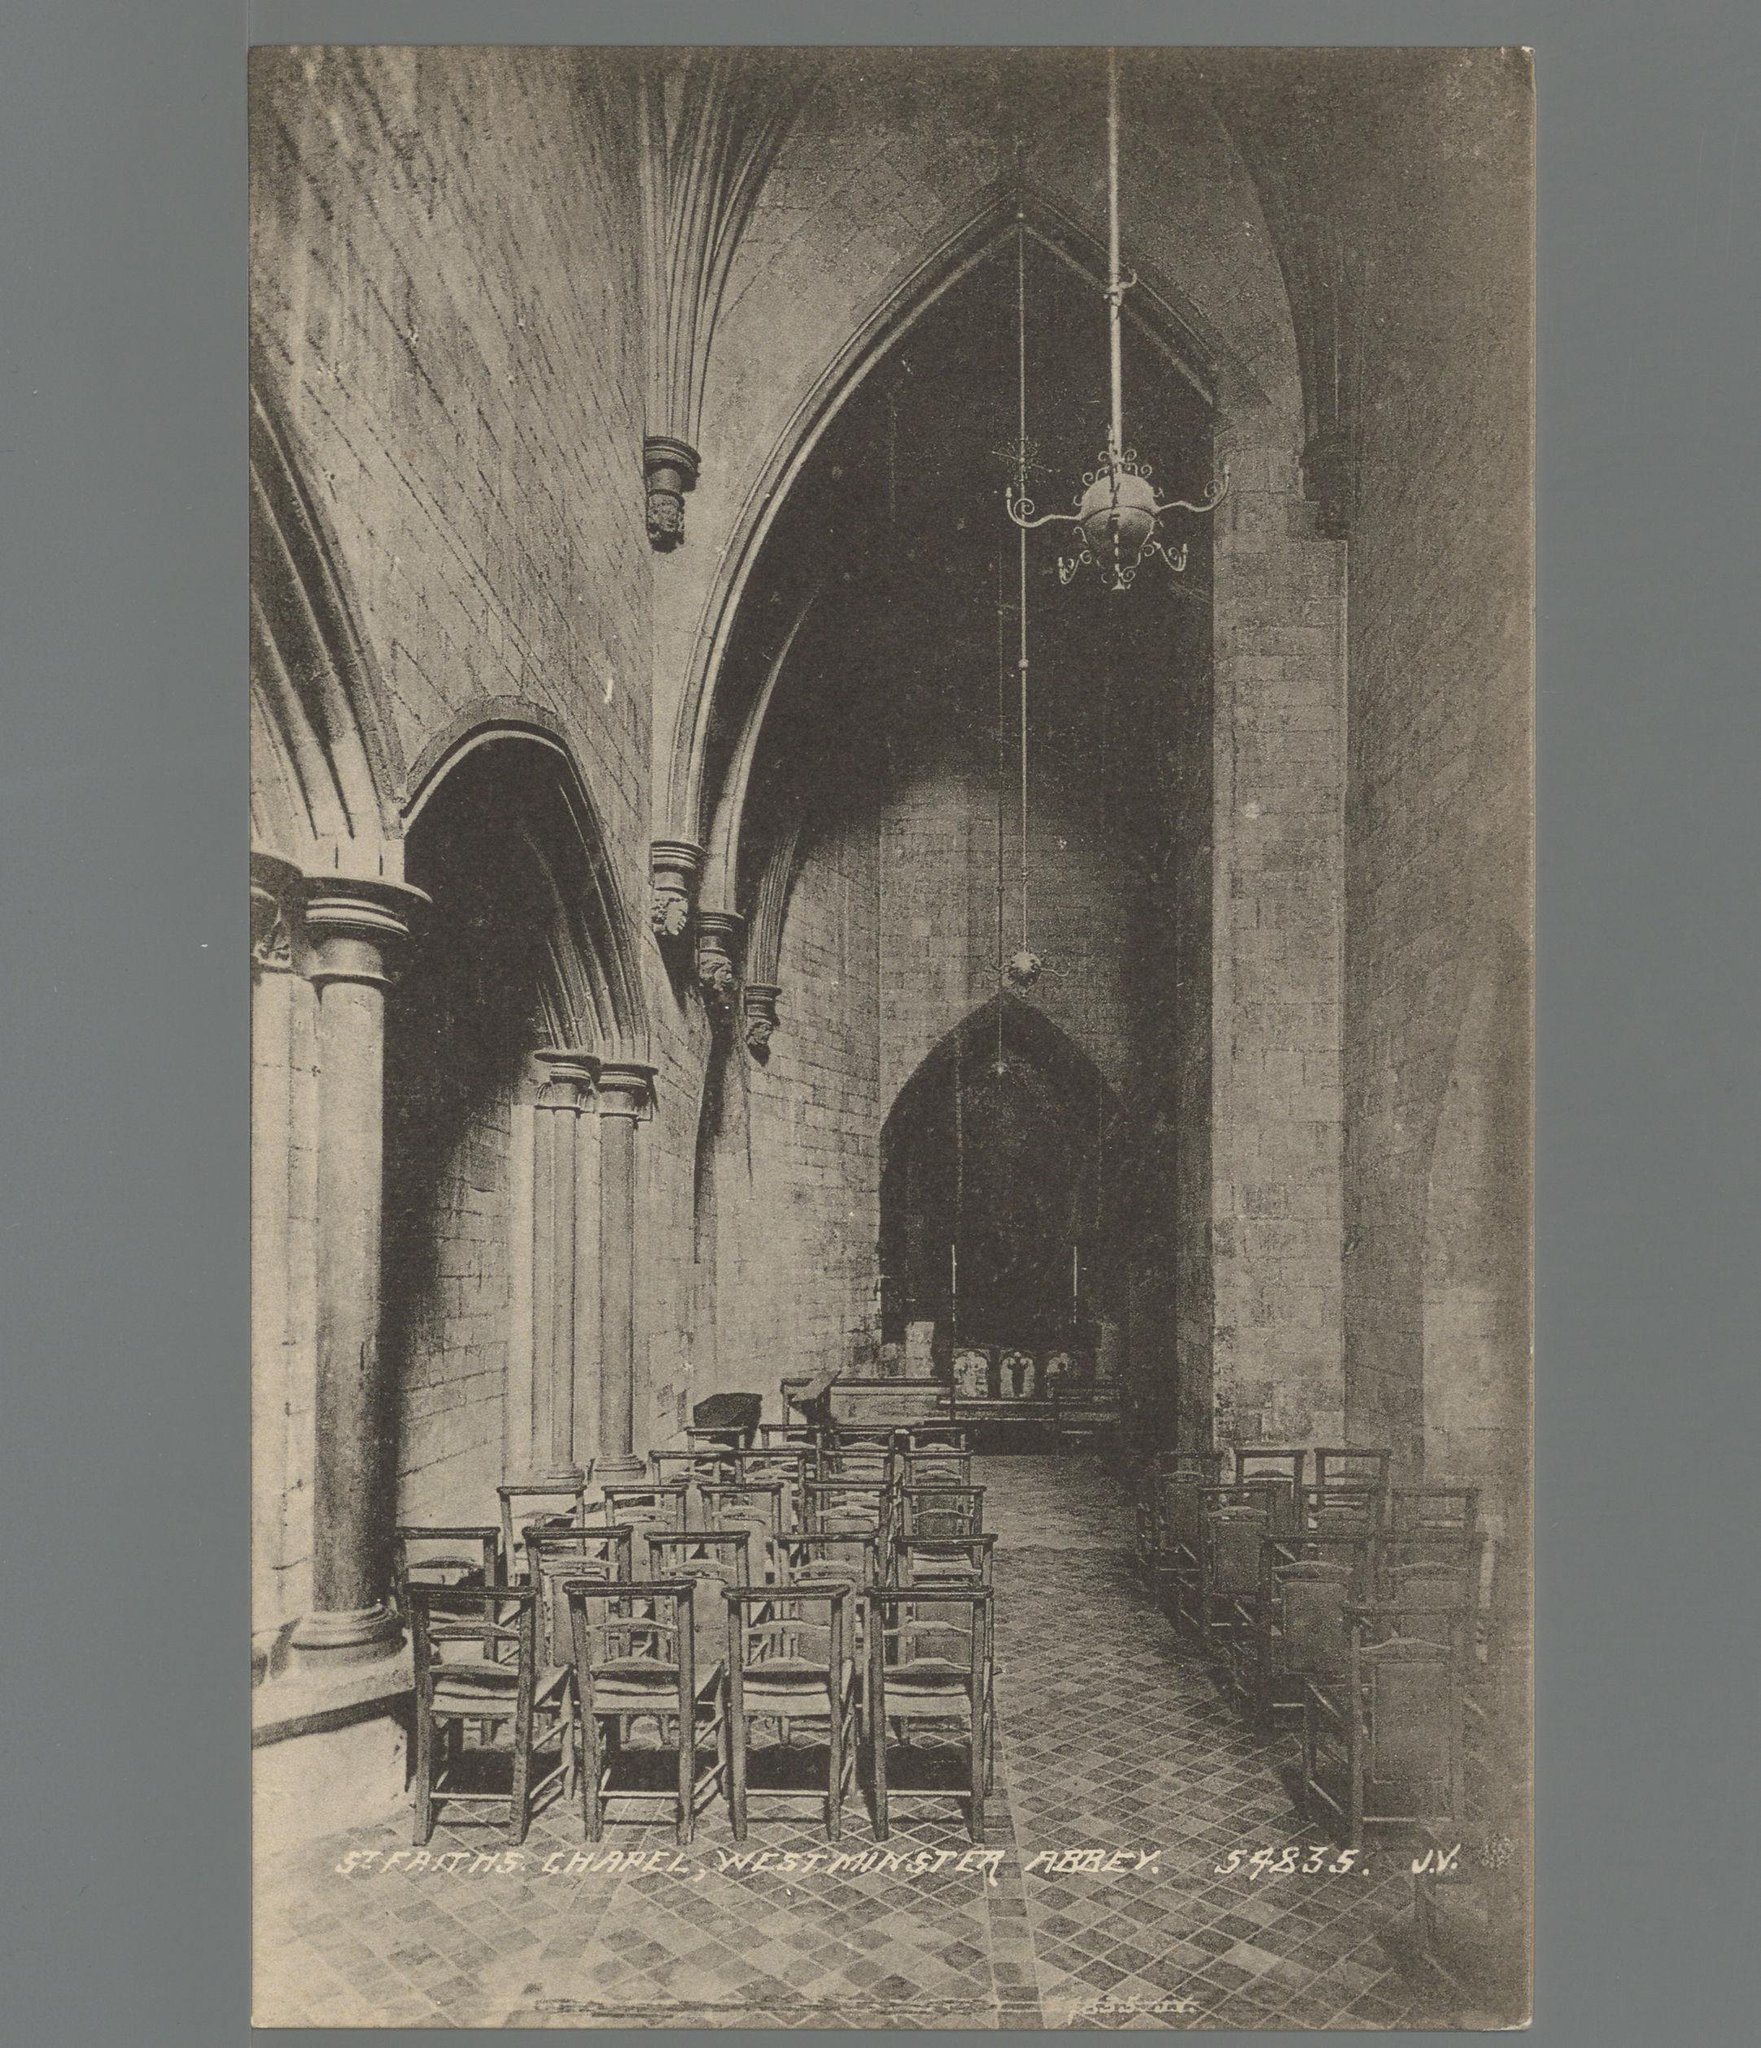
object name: ansichtkaart, prentbriefkaart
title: St. Friths Chapel, Westminster Abbey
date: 1902-1930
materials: cardboard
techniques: photograph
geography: london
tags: parts of church interior: chapel, westminster abbey